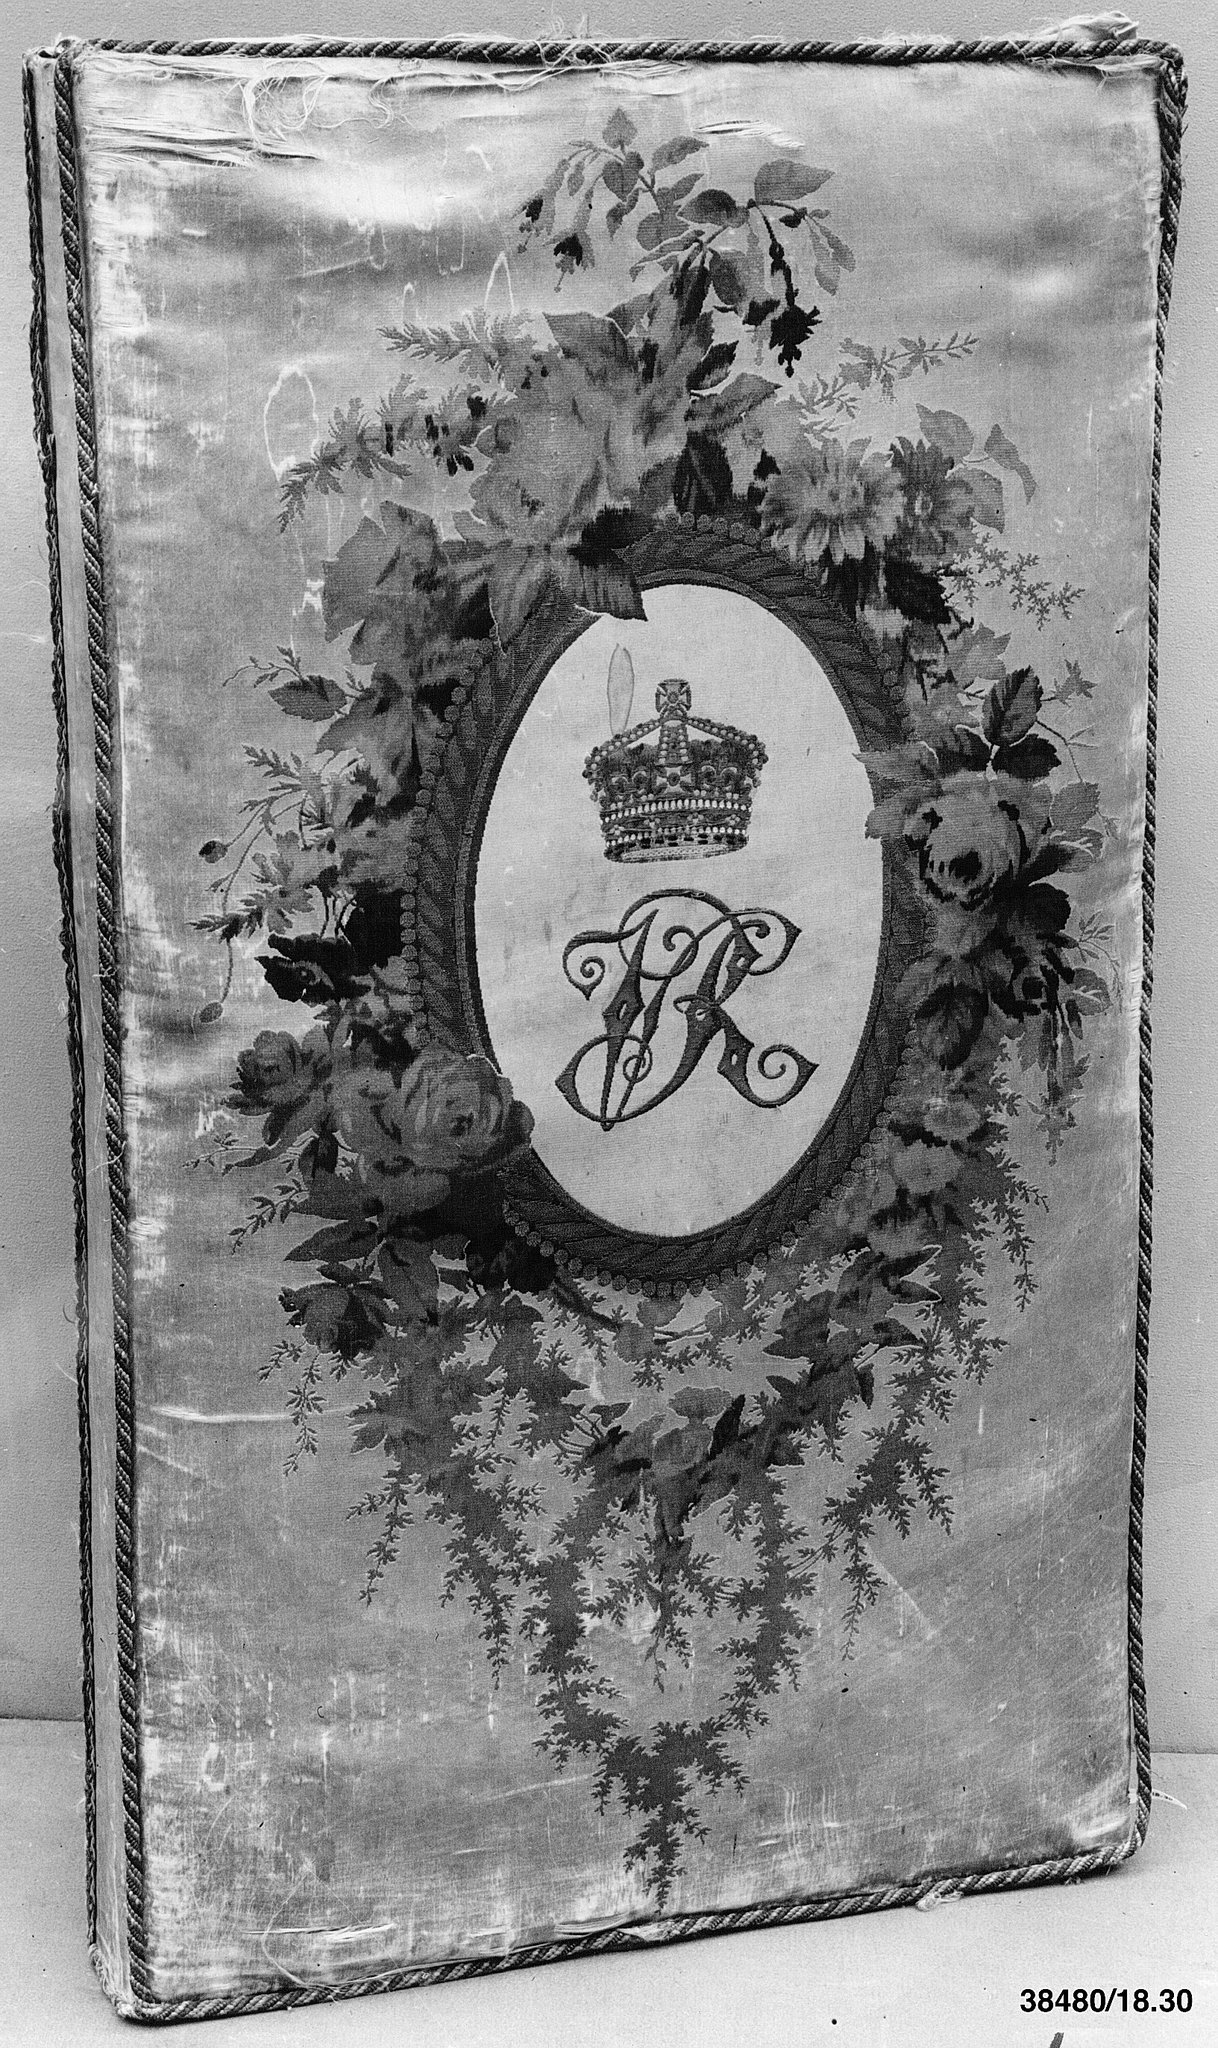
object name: box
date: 1801-1900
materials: metal thread, silk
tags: flowers,leaves,insignia